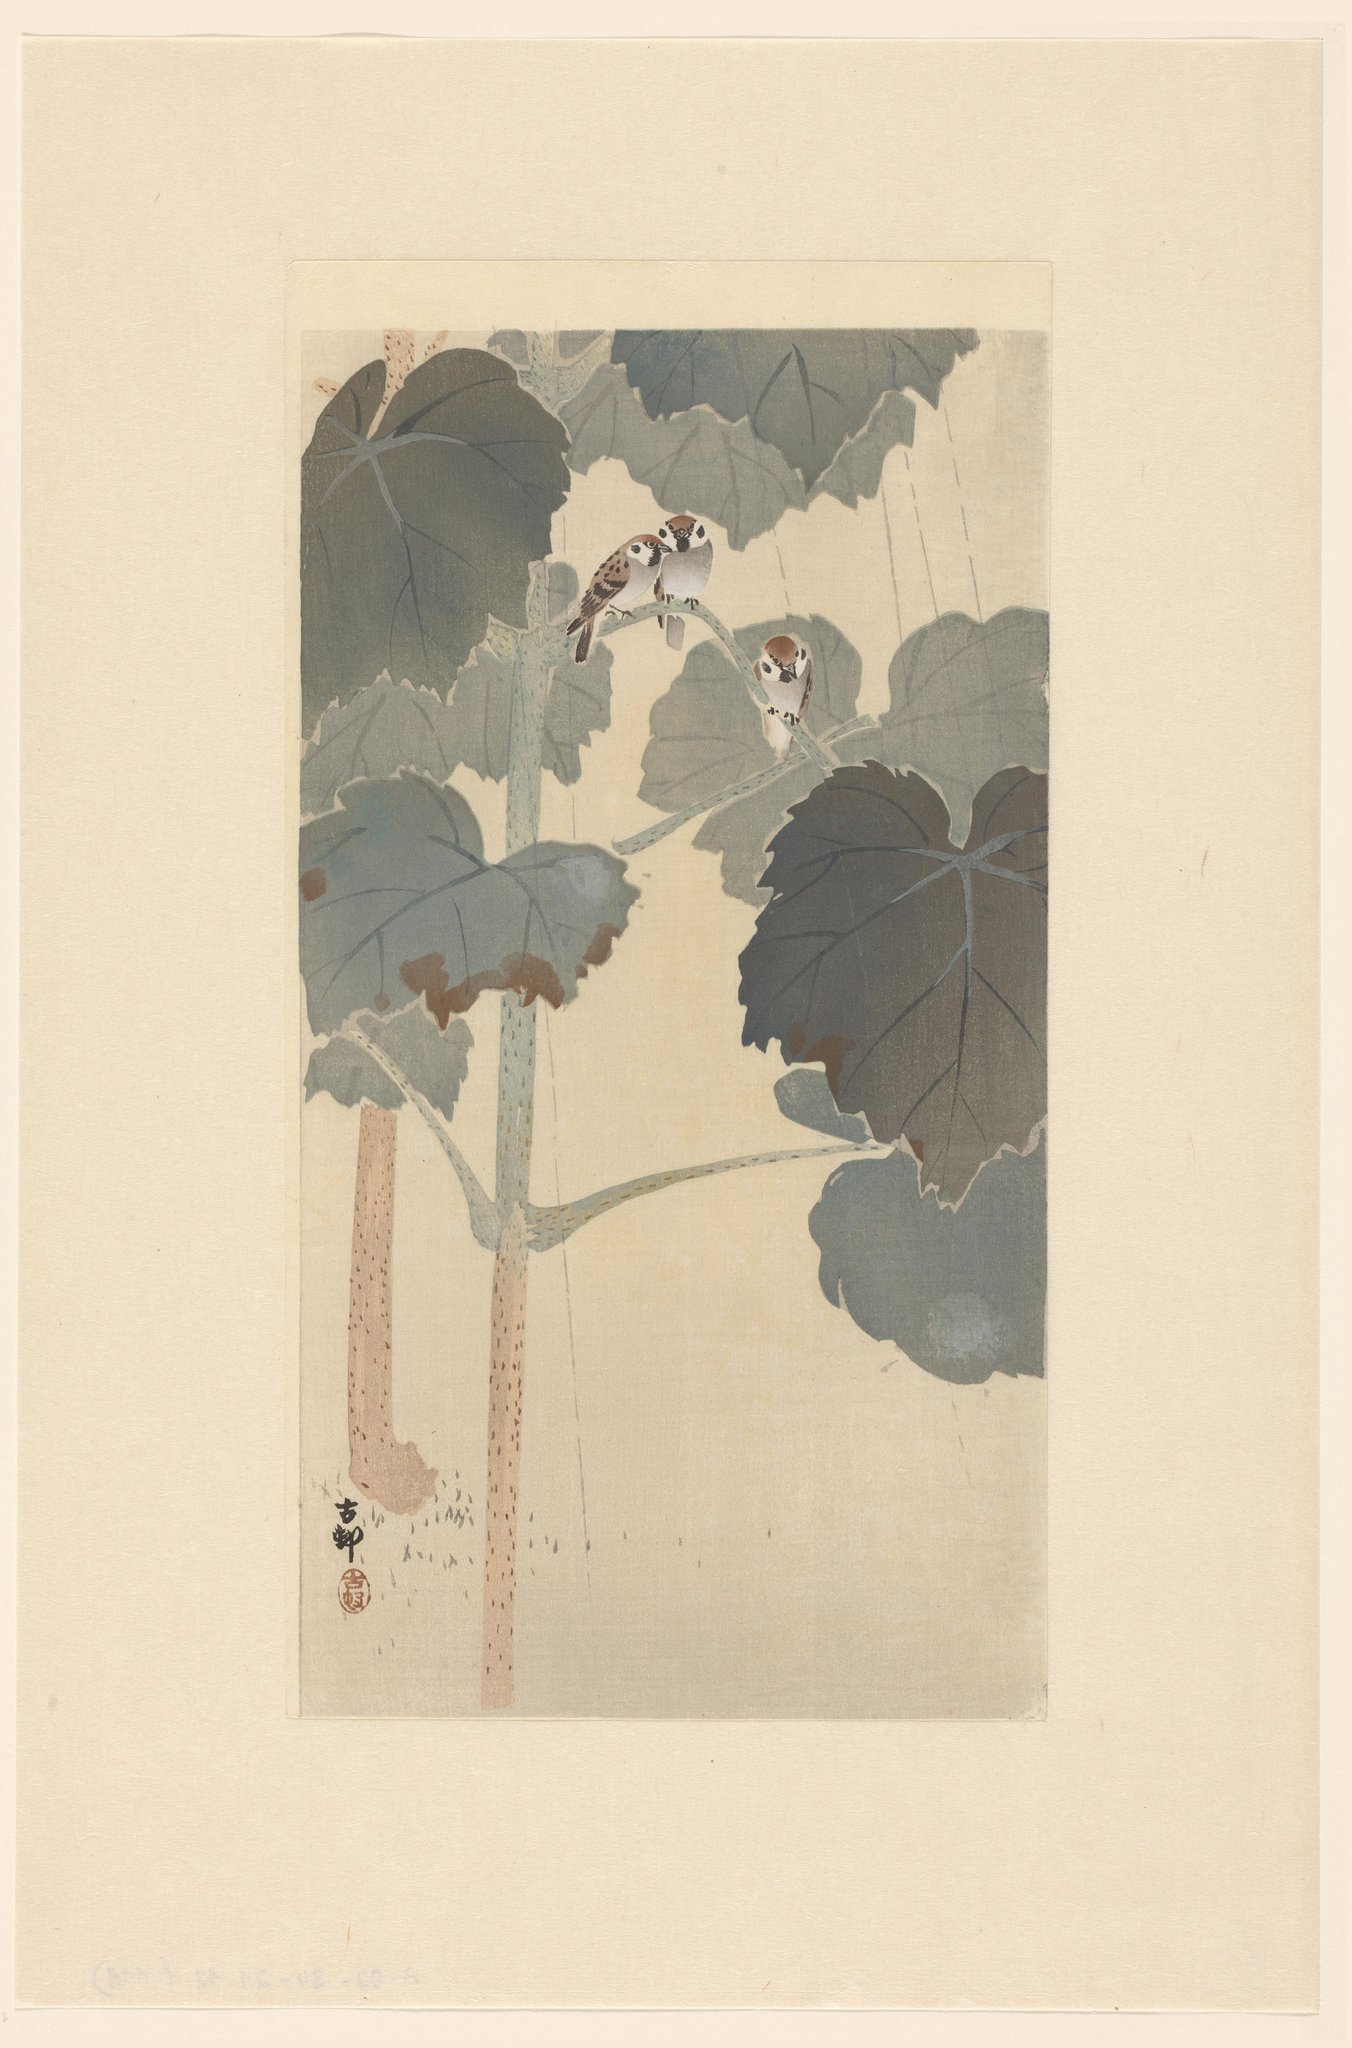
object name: print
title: Mussen in de regen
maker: ohara koson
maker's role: print maker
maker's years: 1877-1945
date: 1900-1930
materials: paper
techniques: woodcut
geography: tokyo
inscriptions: collector's mark: Lugt 2228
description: Drie mussen, op tak van plant met groot blad, in de regen.